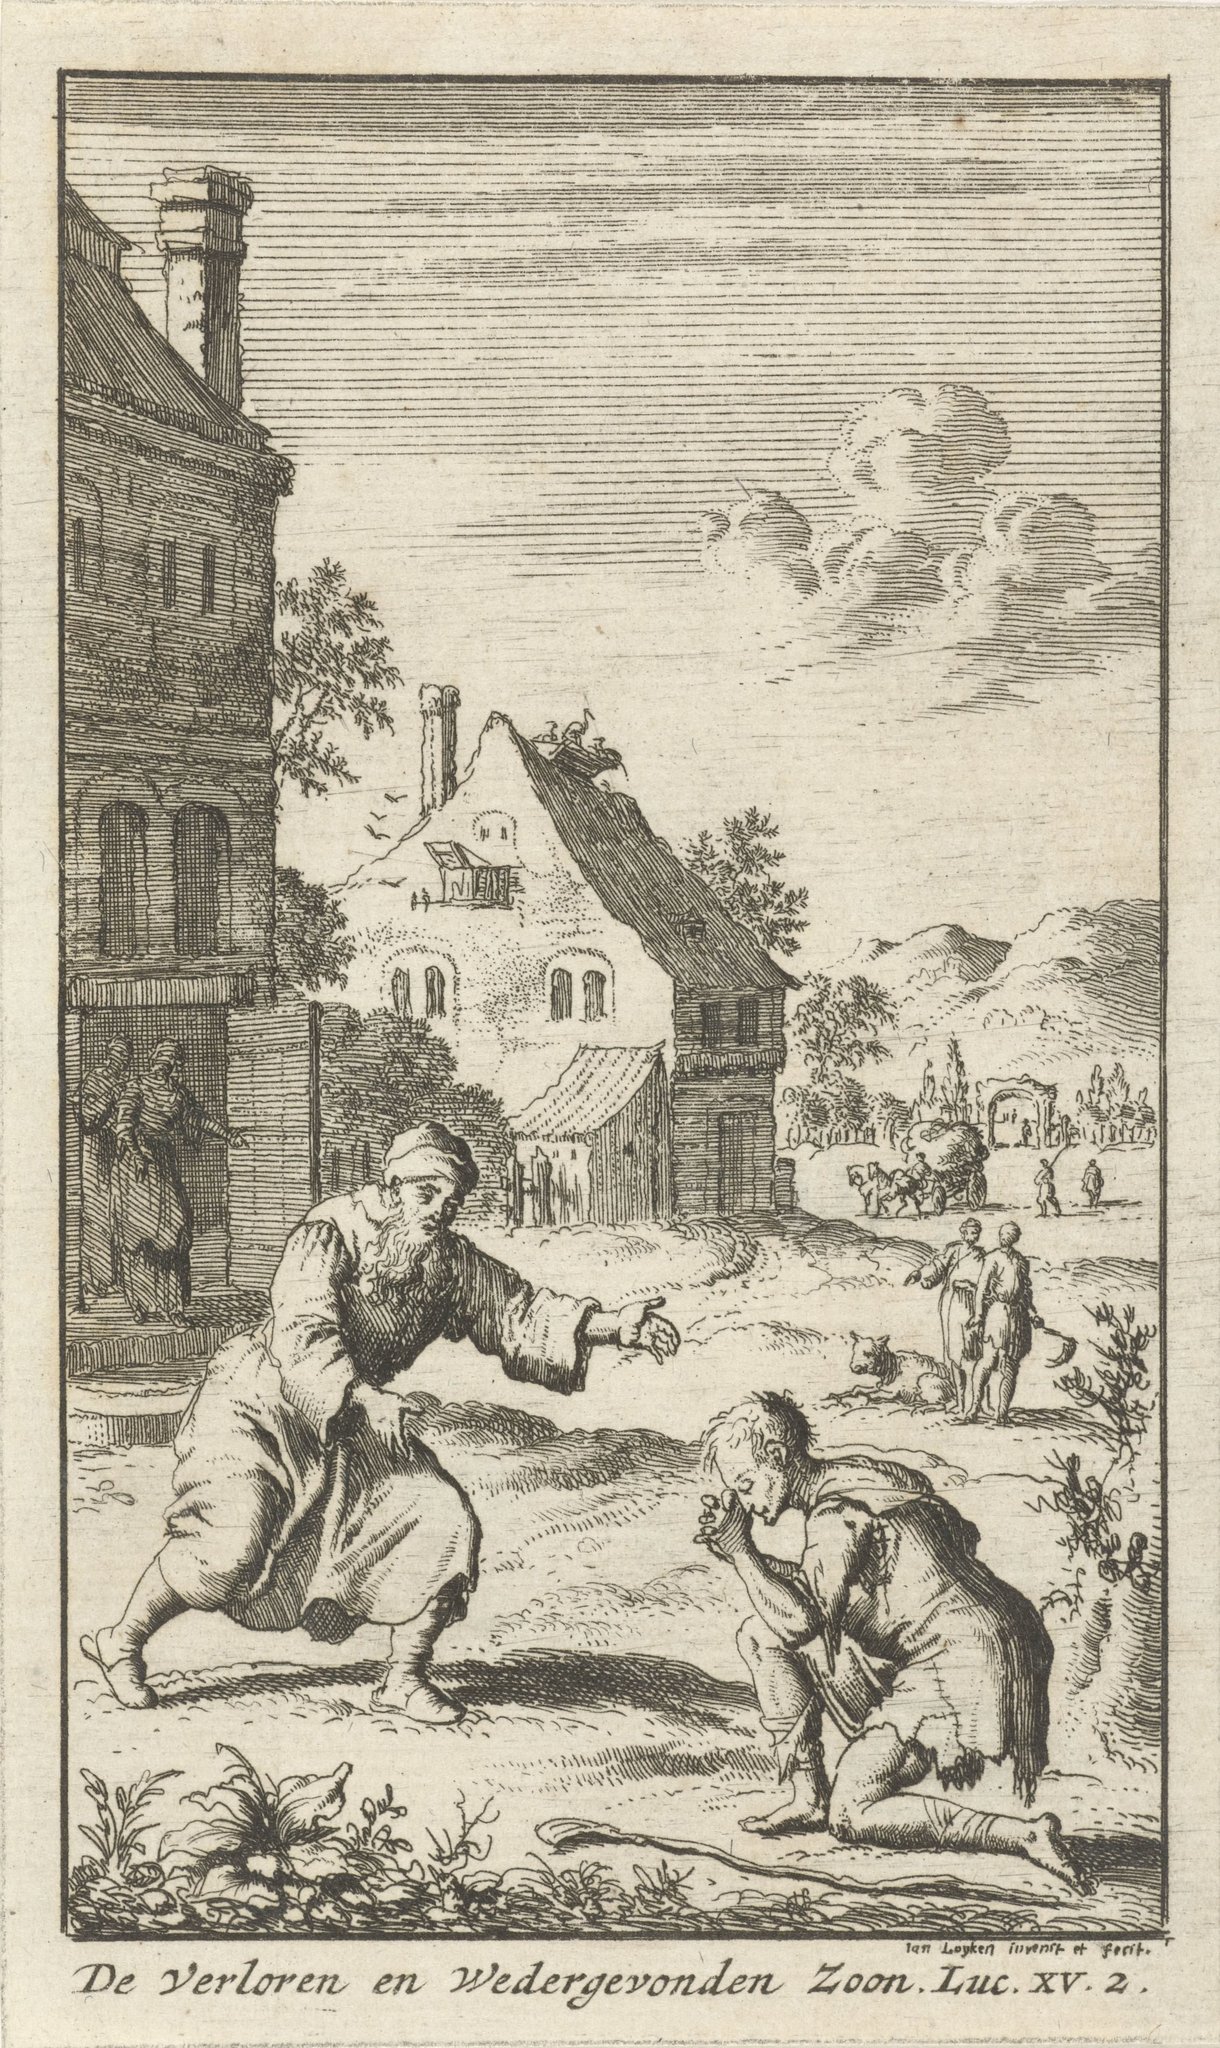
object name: print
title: De Verloren en Wedergevonden Zoon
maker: jan luyken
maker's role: draughtsman, print maker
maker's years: 1649-1712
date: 1727-1729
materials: paper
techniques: etching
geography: amsterdam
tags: the parable of the prodigal son (luke 15:11-32)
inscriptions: collector's mark: Lugt 2228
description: Prent opgenomen in: Het Nieuwe Testament ofte alle Boecken des Nieuwen Verbondts onses Heeren Iesu Christi. Dordrecht: Pieter en Jacob Keur, 172X (niet voor 1727). In dit werk is de complete vierentwintigdelige serie opgenomen. De prenten werden, hetzij alle tezamen, hetzij gedeeltelijk, veel gebruikt tot versiering van Nieuwe Testamenten en verschenen tevens in kopie.